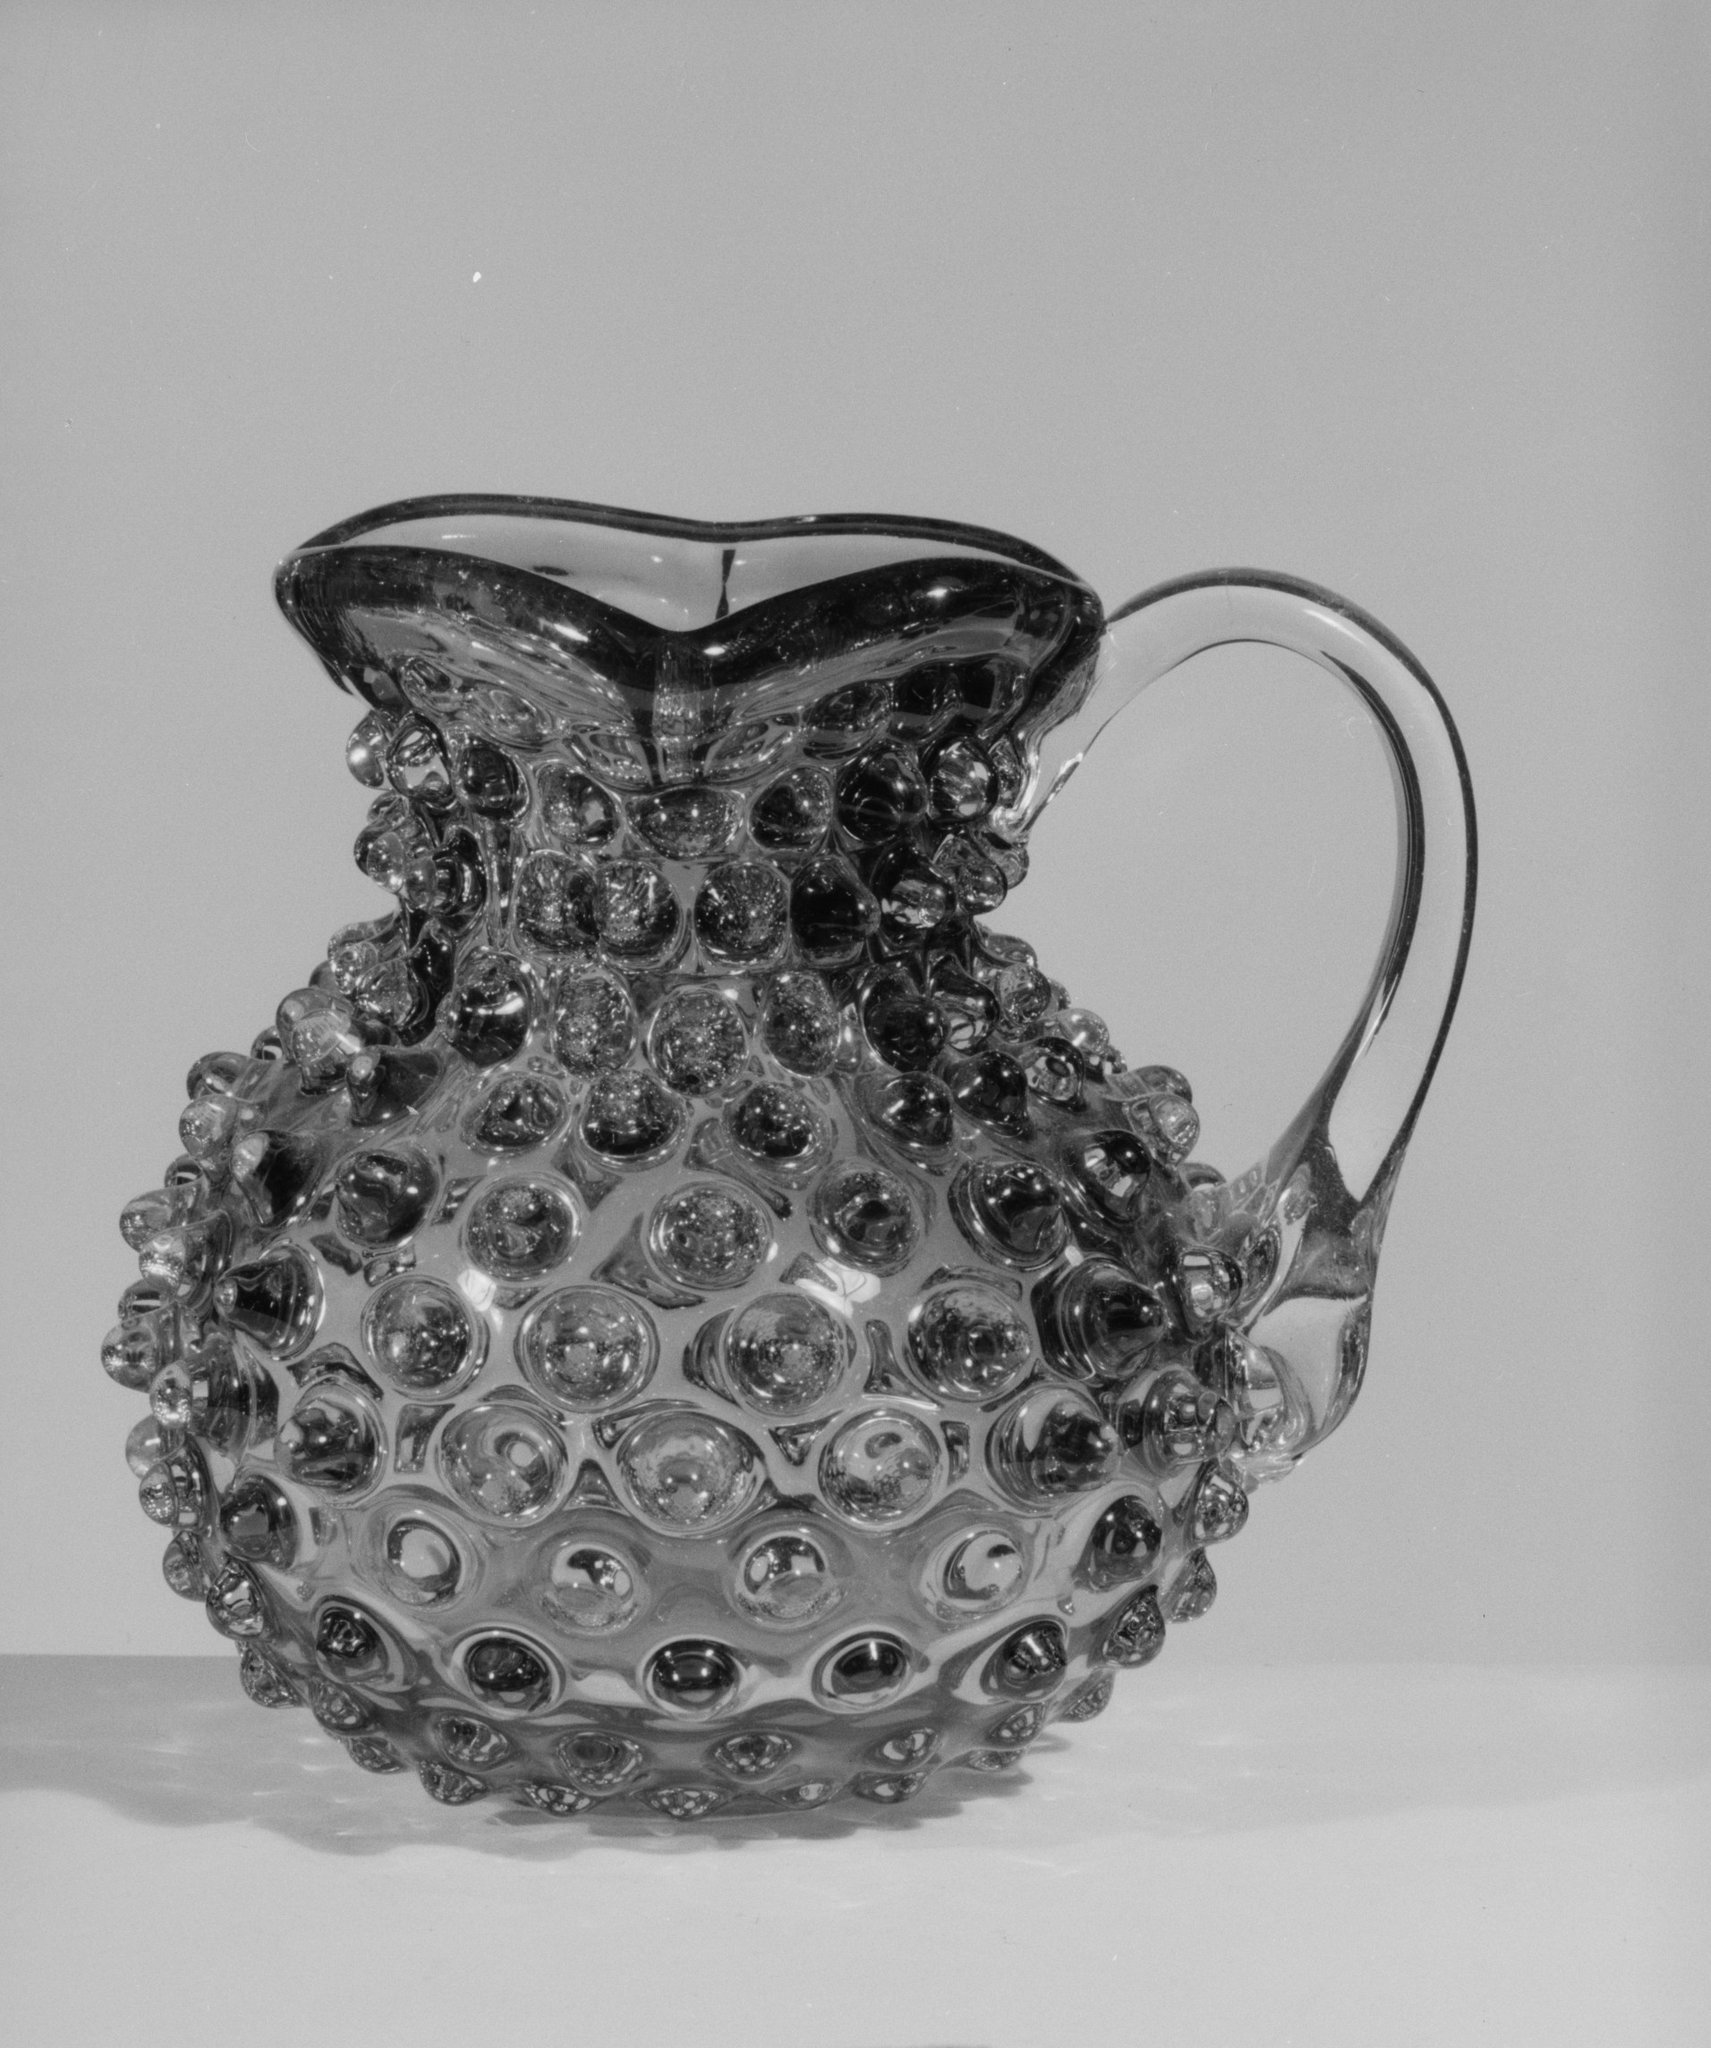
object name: cream pot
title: Hobnail Creamer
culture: american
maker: hobbs, brockunier and company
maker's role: maker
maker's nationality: american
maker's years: 1863-1891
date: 1886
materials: glass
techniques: pressed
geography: united states